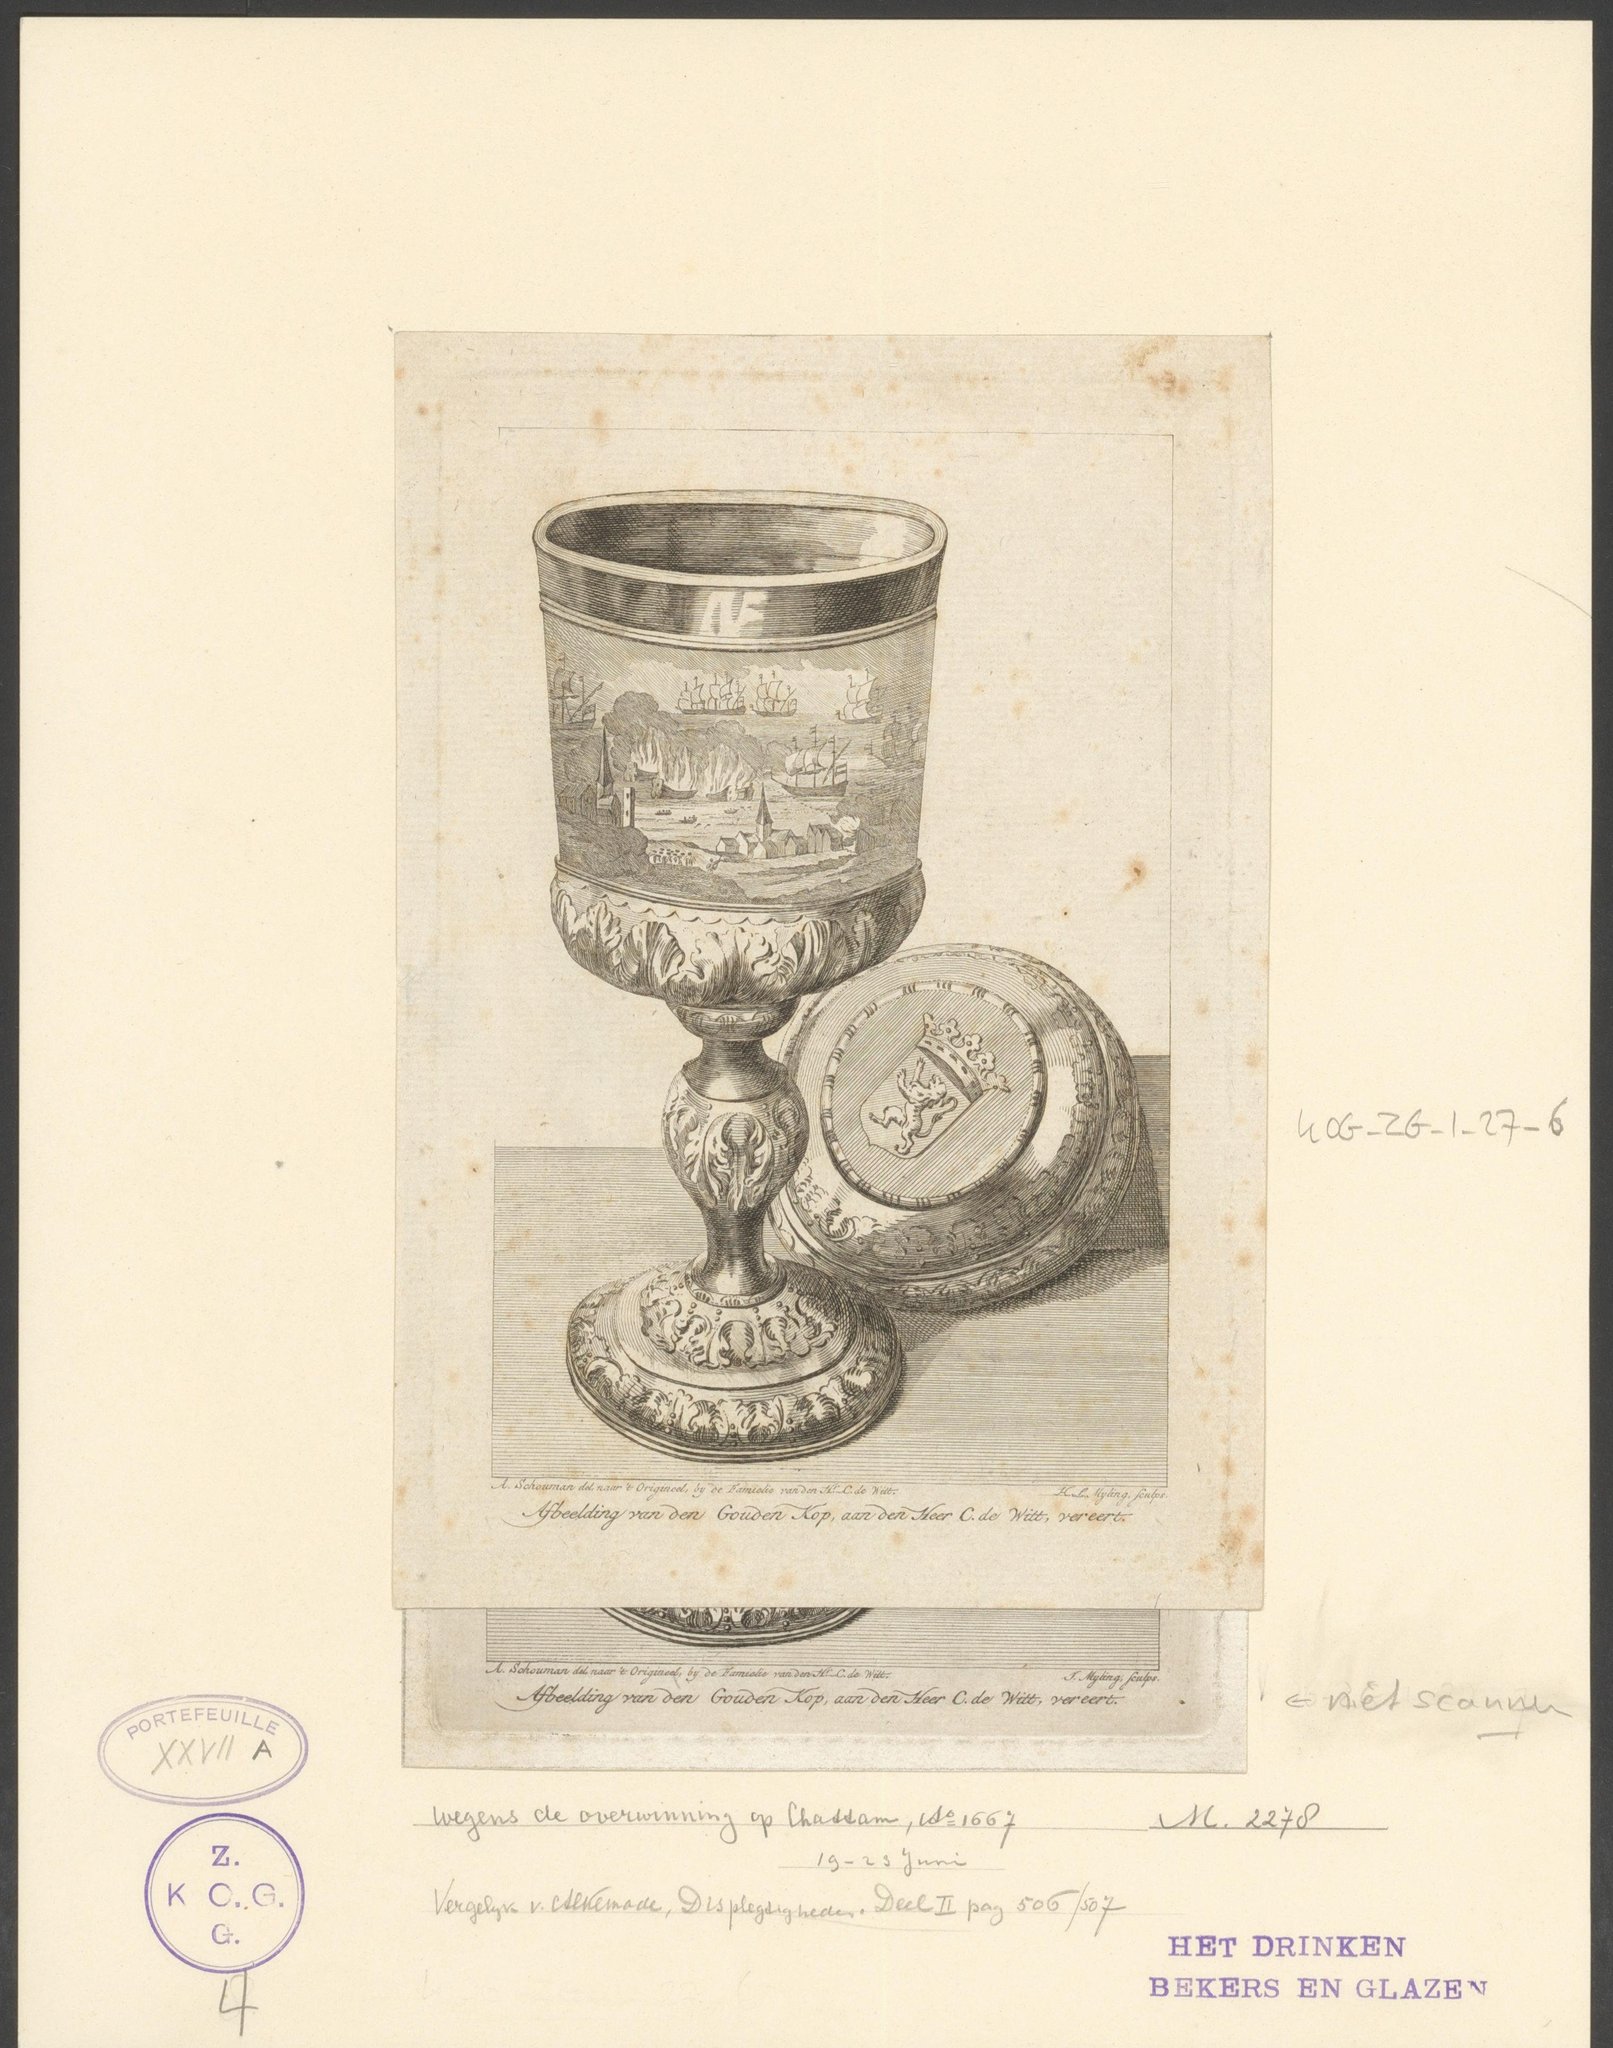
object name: print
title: Afbeelding van den Gouden Kop, aan den Heer C. de Witt, vereert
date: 1777-1821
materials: paper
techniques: etching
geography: netherlands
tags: dordrecht, the hague, cornelis de witt, sailing-ship, sailing-boat, cup, alcoholic drinks, raid on the medway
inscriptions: collector's mark: Lugt 1641, collector's mark